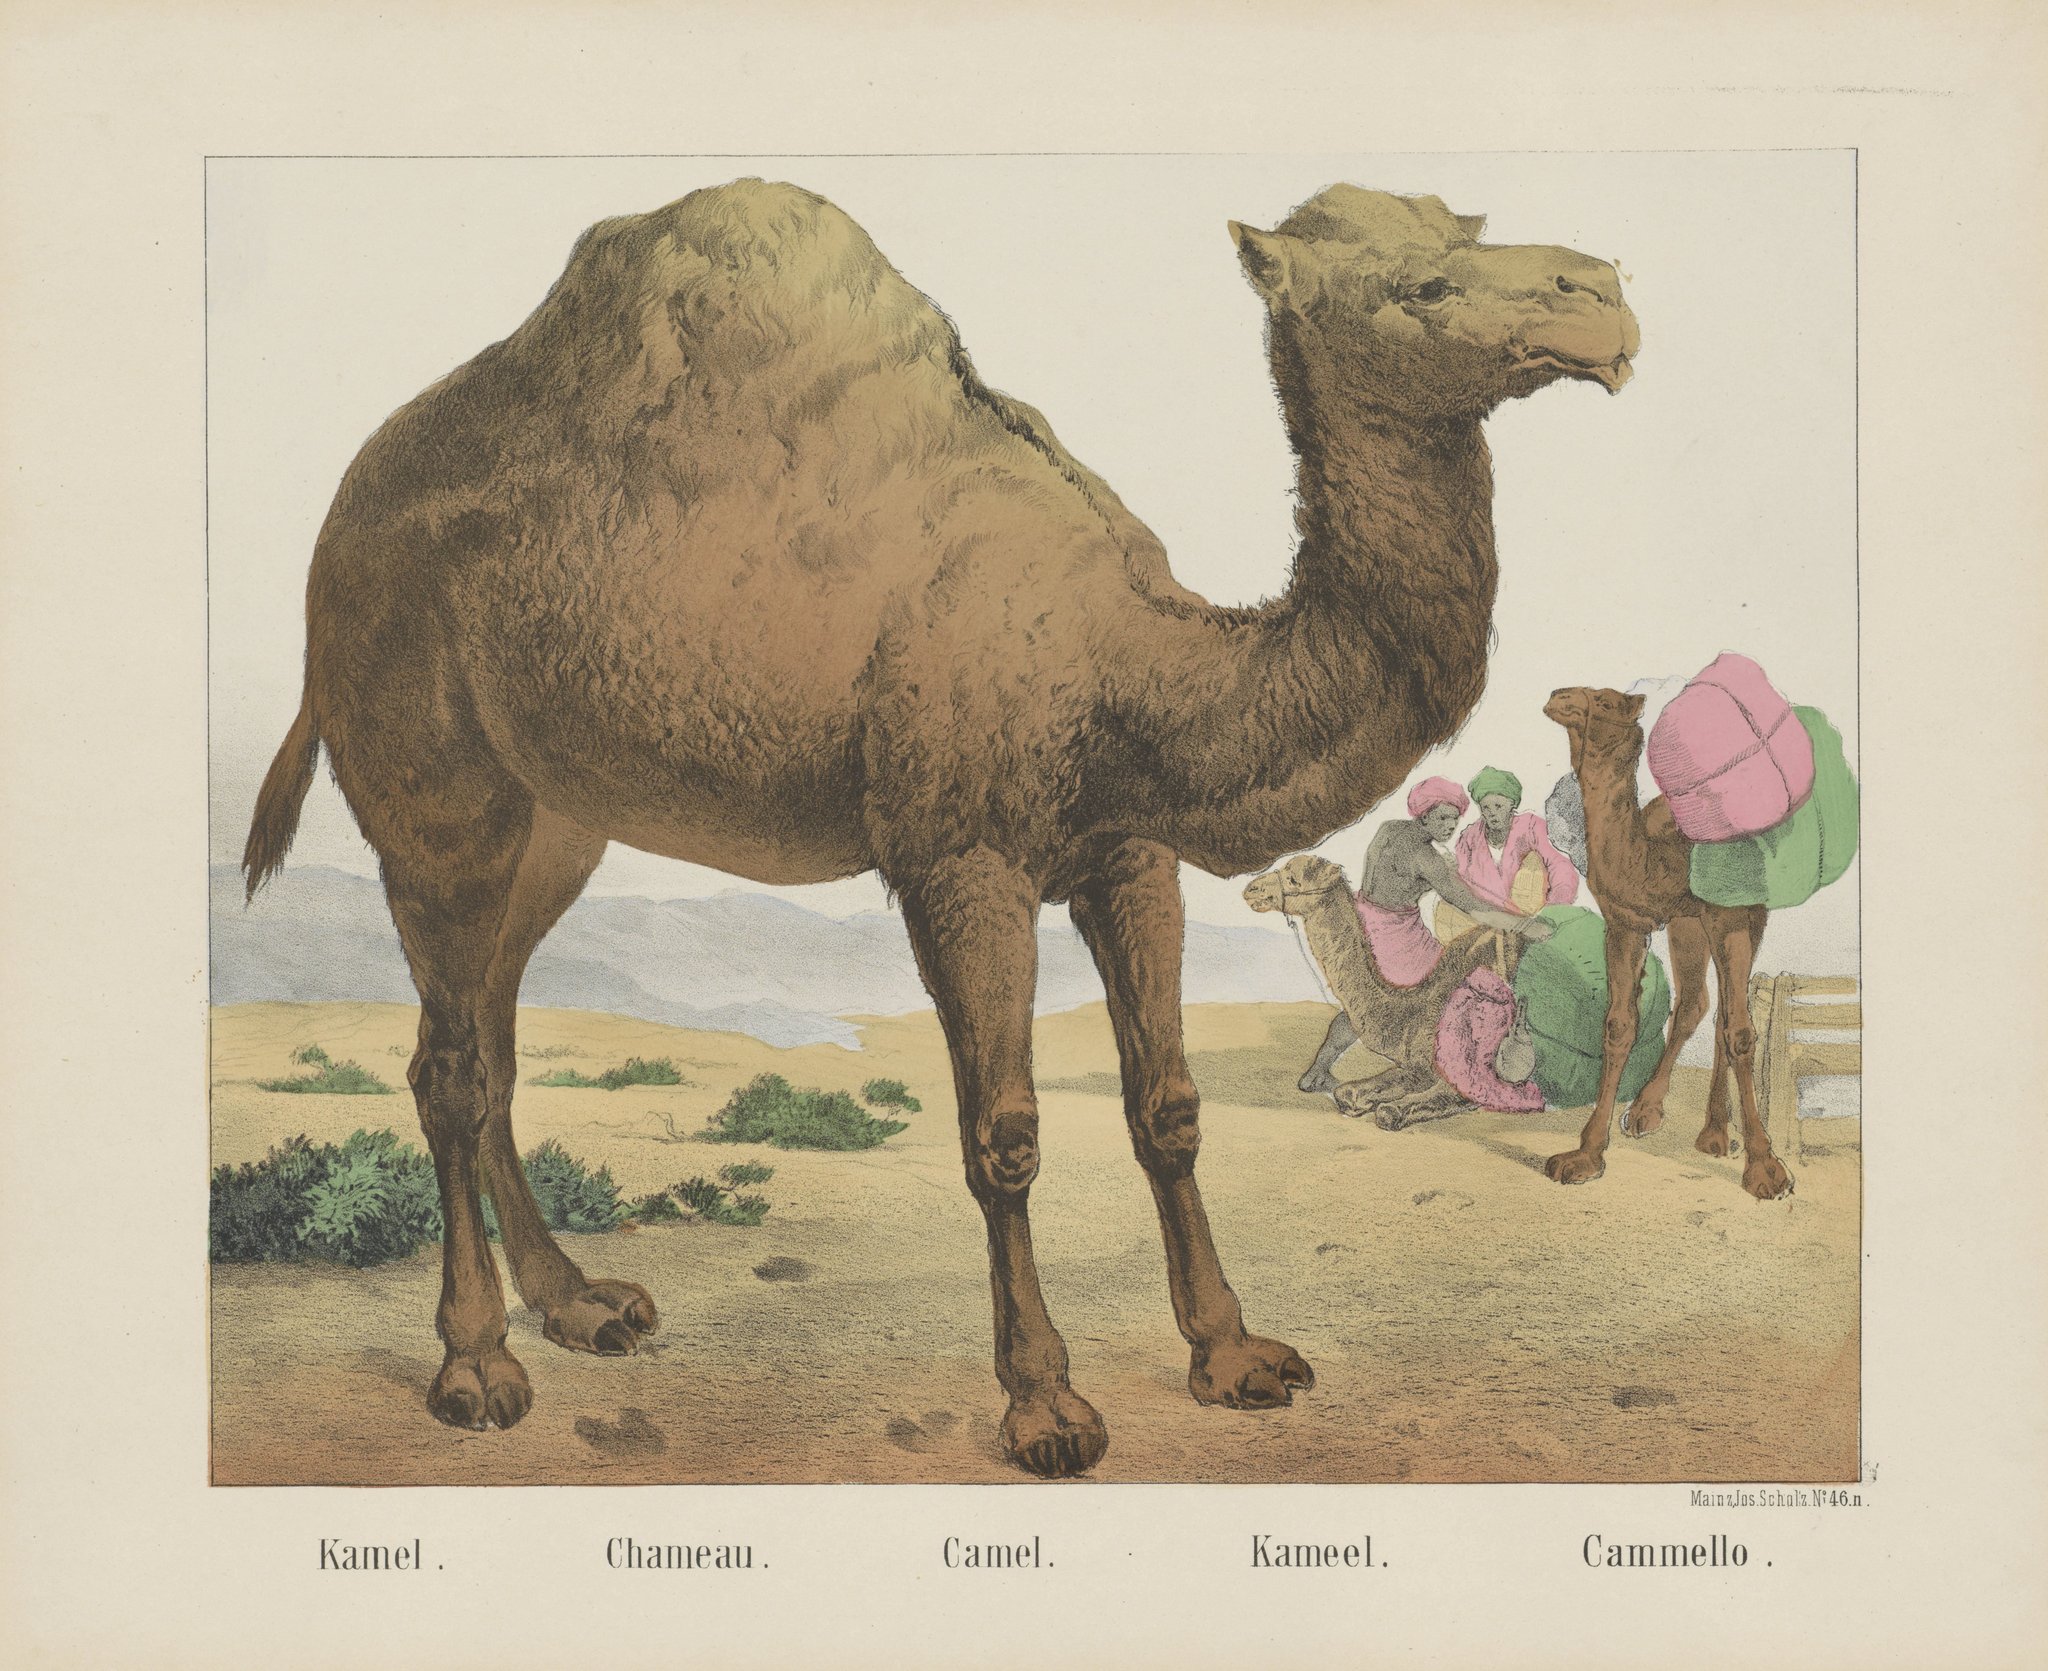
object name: popular print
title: Kamel. / Chameau. / Camel. / Kameel. / Cammello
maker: Anonymous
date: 1829-1880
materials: paper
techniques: colour, letterpress printing, lithograph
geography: mainz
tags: hoofed animals: dromedary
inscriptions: collector's mark: Lugt 2760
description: Drie dromedarissen (de titel zegt kameel) in een woestijn landschap. De twee dromedarissen meer op de achtergrond worden bepakt door twee mannen. Genummerd rechtsonder: No. 46n.